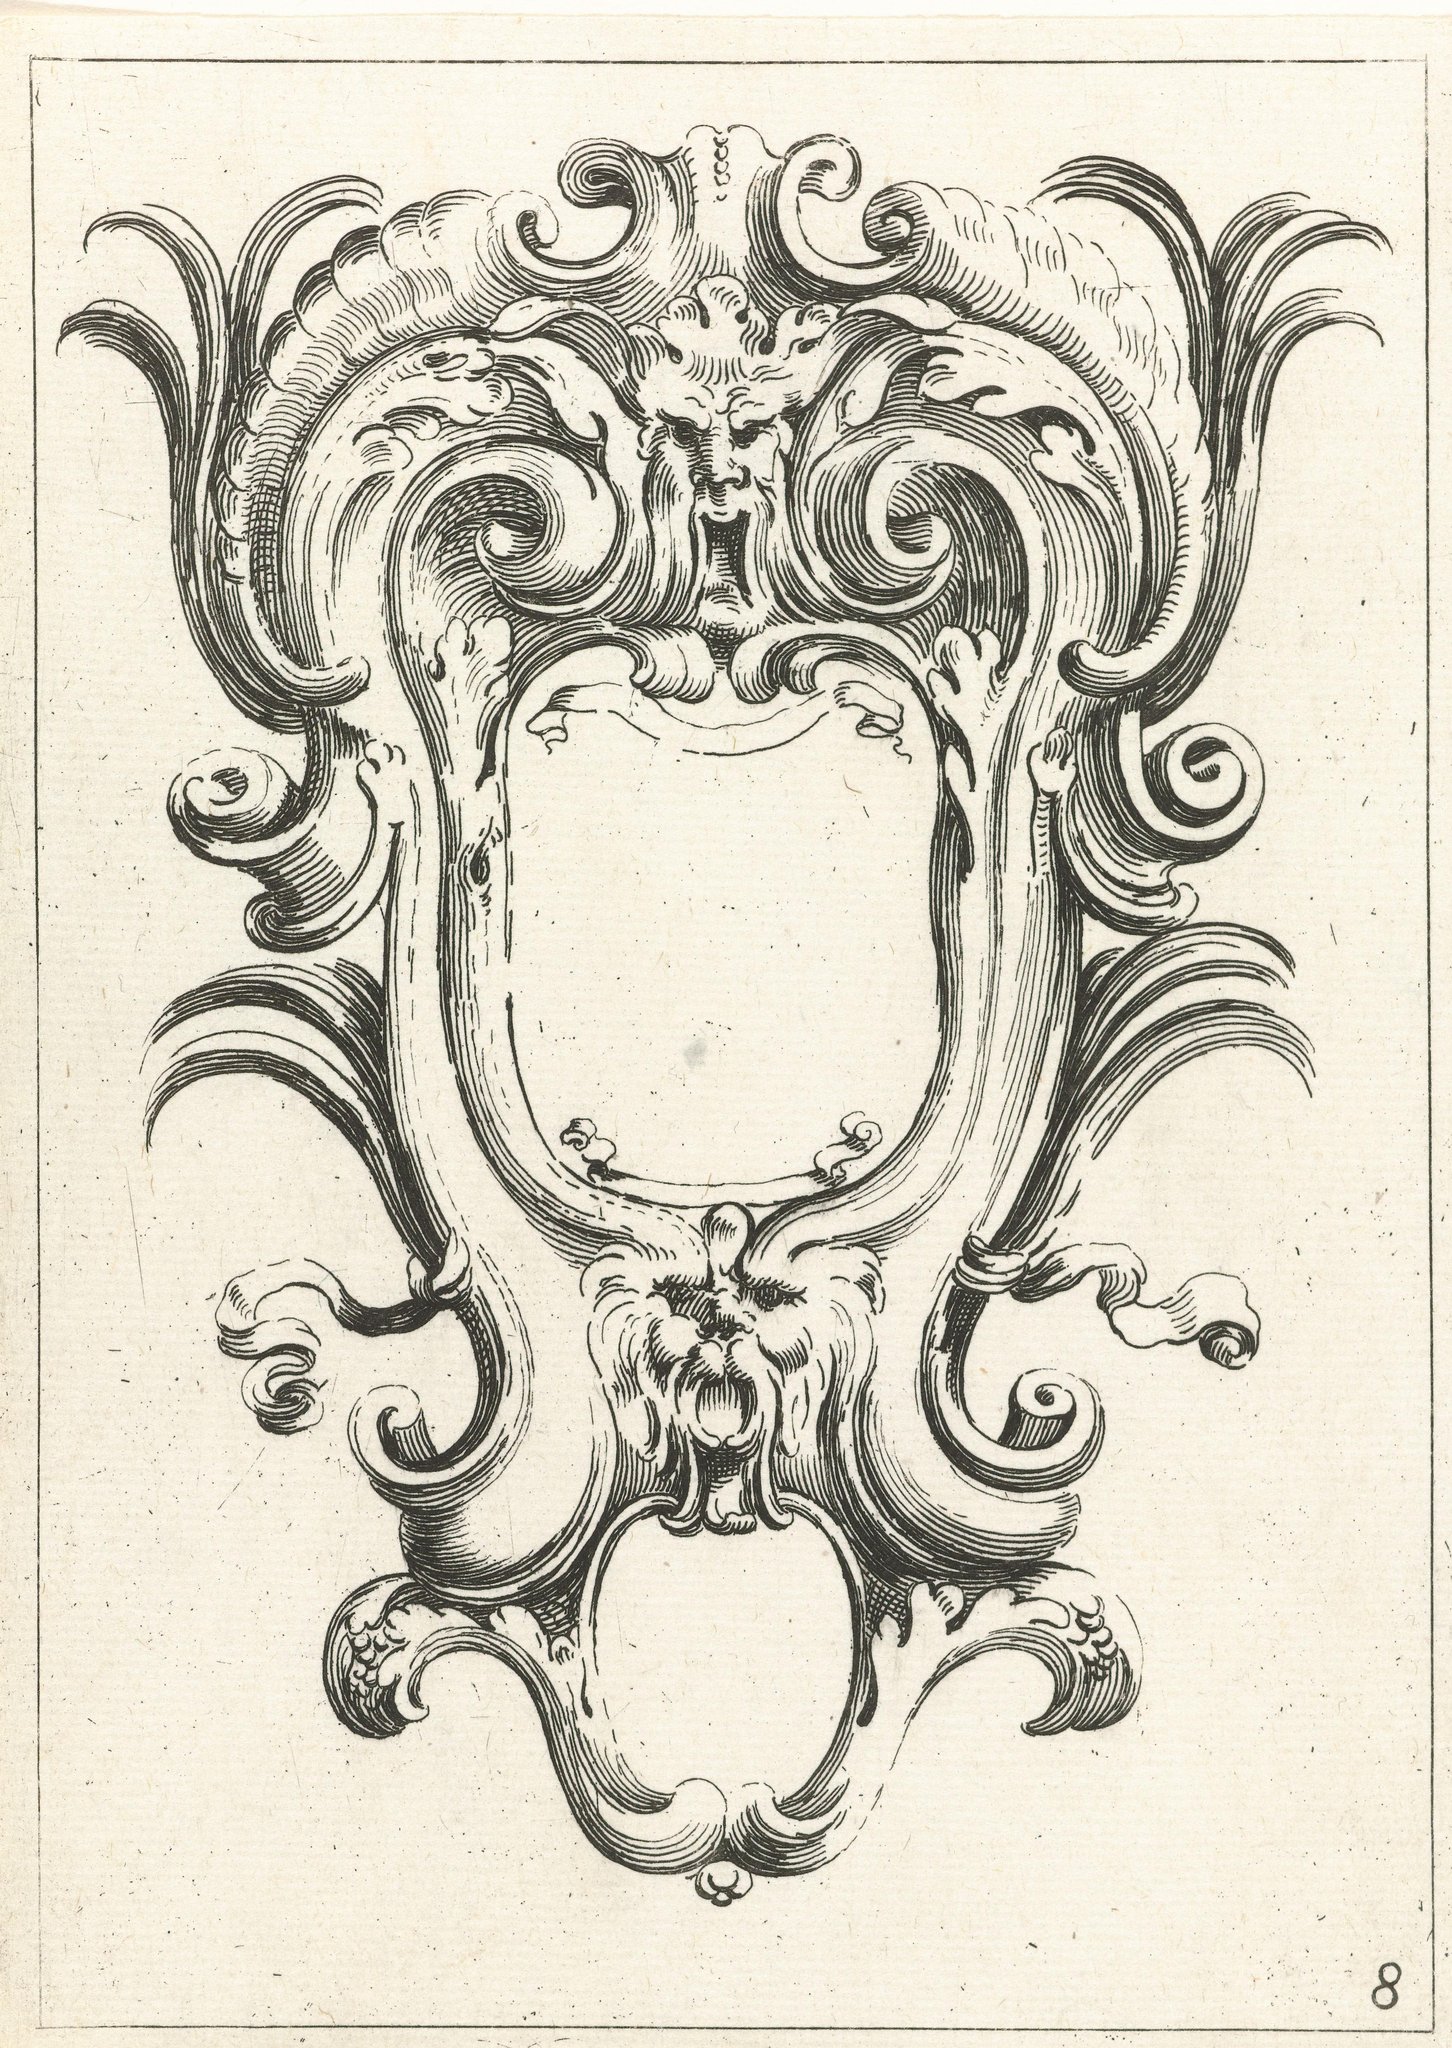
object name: ornament print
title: Blad uit serie met cartouches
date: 1642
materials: paper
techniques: etching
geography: paris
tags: ornament ~ cartouche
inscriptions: watermark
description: Achtste prent uit een serie van twaalf met kopieën naar een serie met cartouches. Cartouche gedecoreerd met twee maskers. Twee banderollen op cartouche.